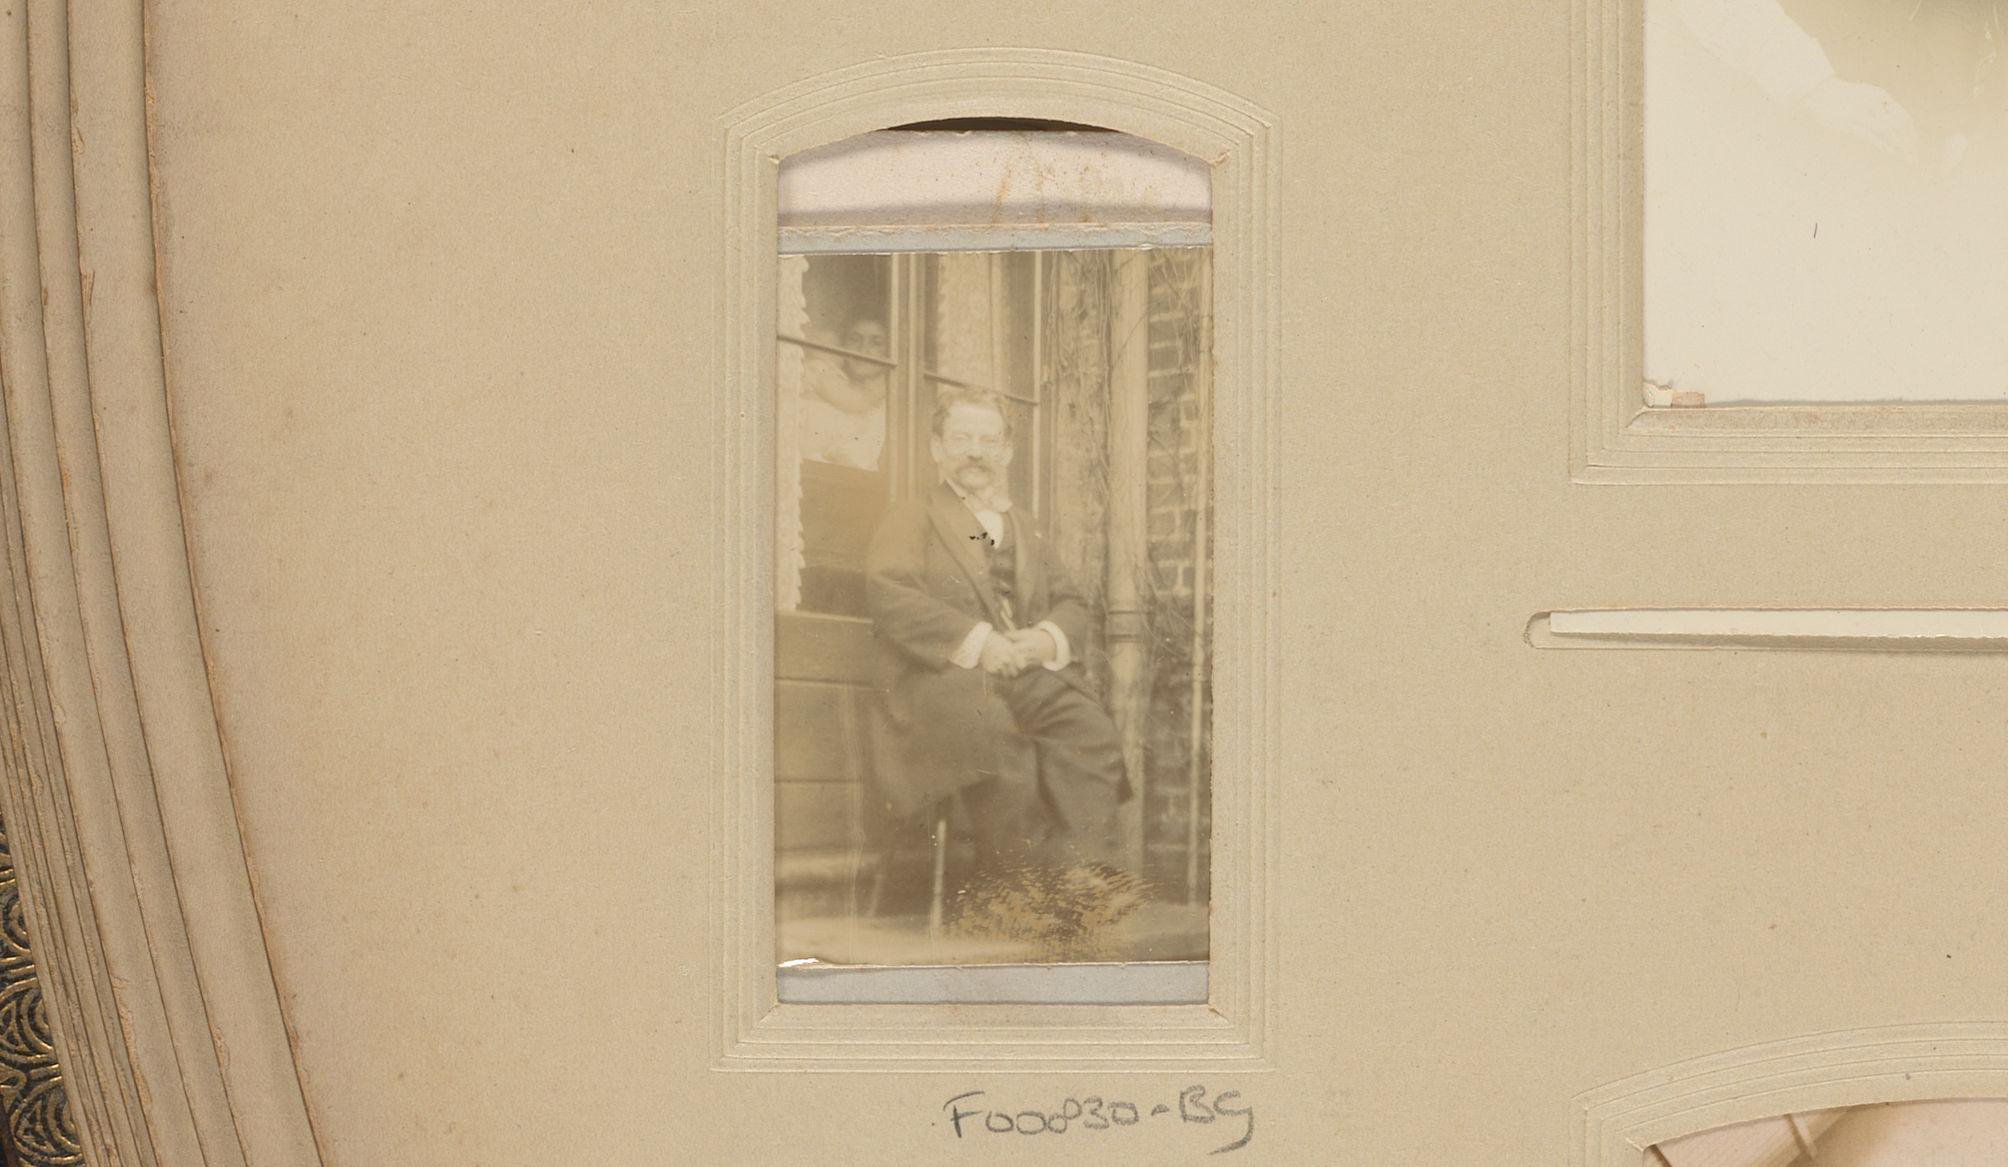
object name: album leaf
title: Portret van een zittende man voor een huis en een vrouw met baby achter het raam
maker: john h. williams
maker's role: fotograaf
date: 1890-1910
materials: cardboard, photographic support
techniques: collodion silver print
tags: adult man, historical persons, mother and child(ren), woman and child(ren) (family group)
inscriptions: inscription: ‘John H. Williams/ Phototgrapher/ 42, Hornsey Park Rd London, N.’